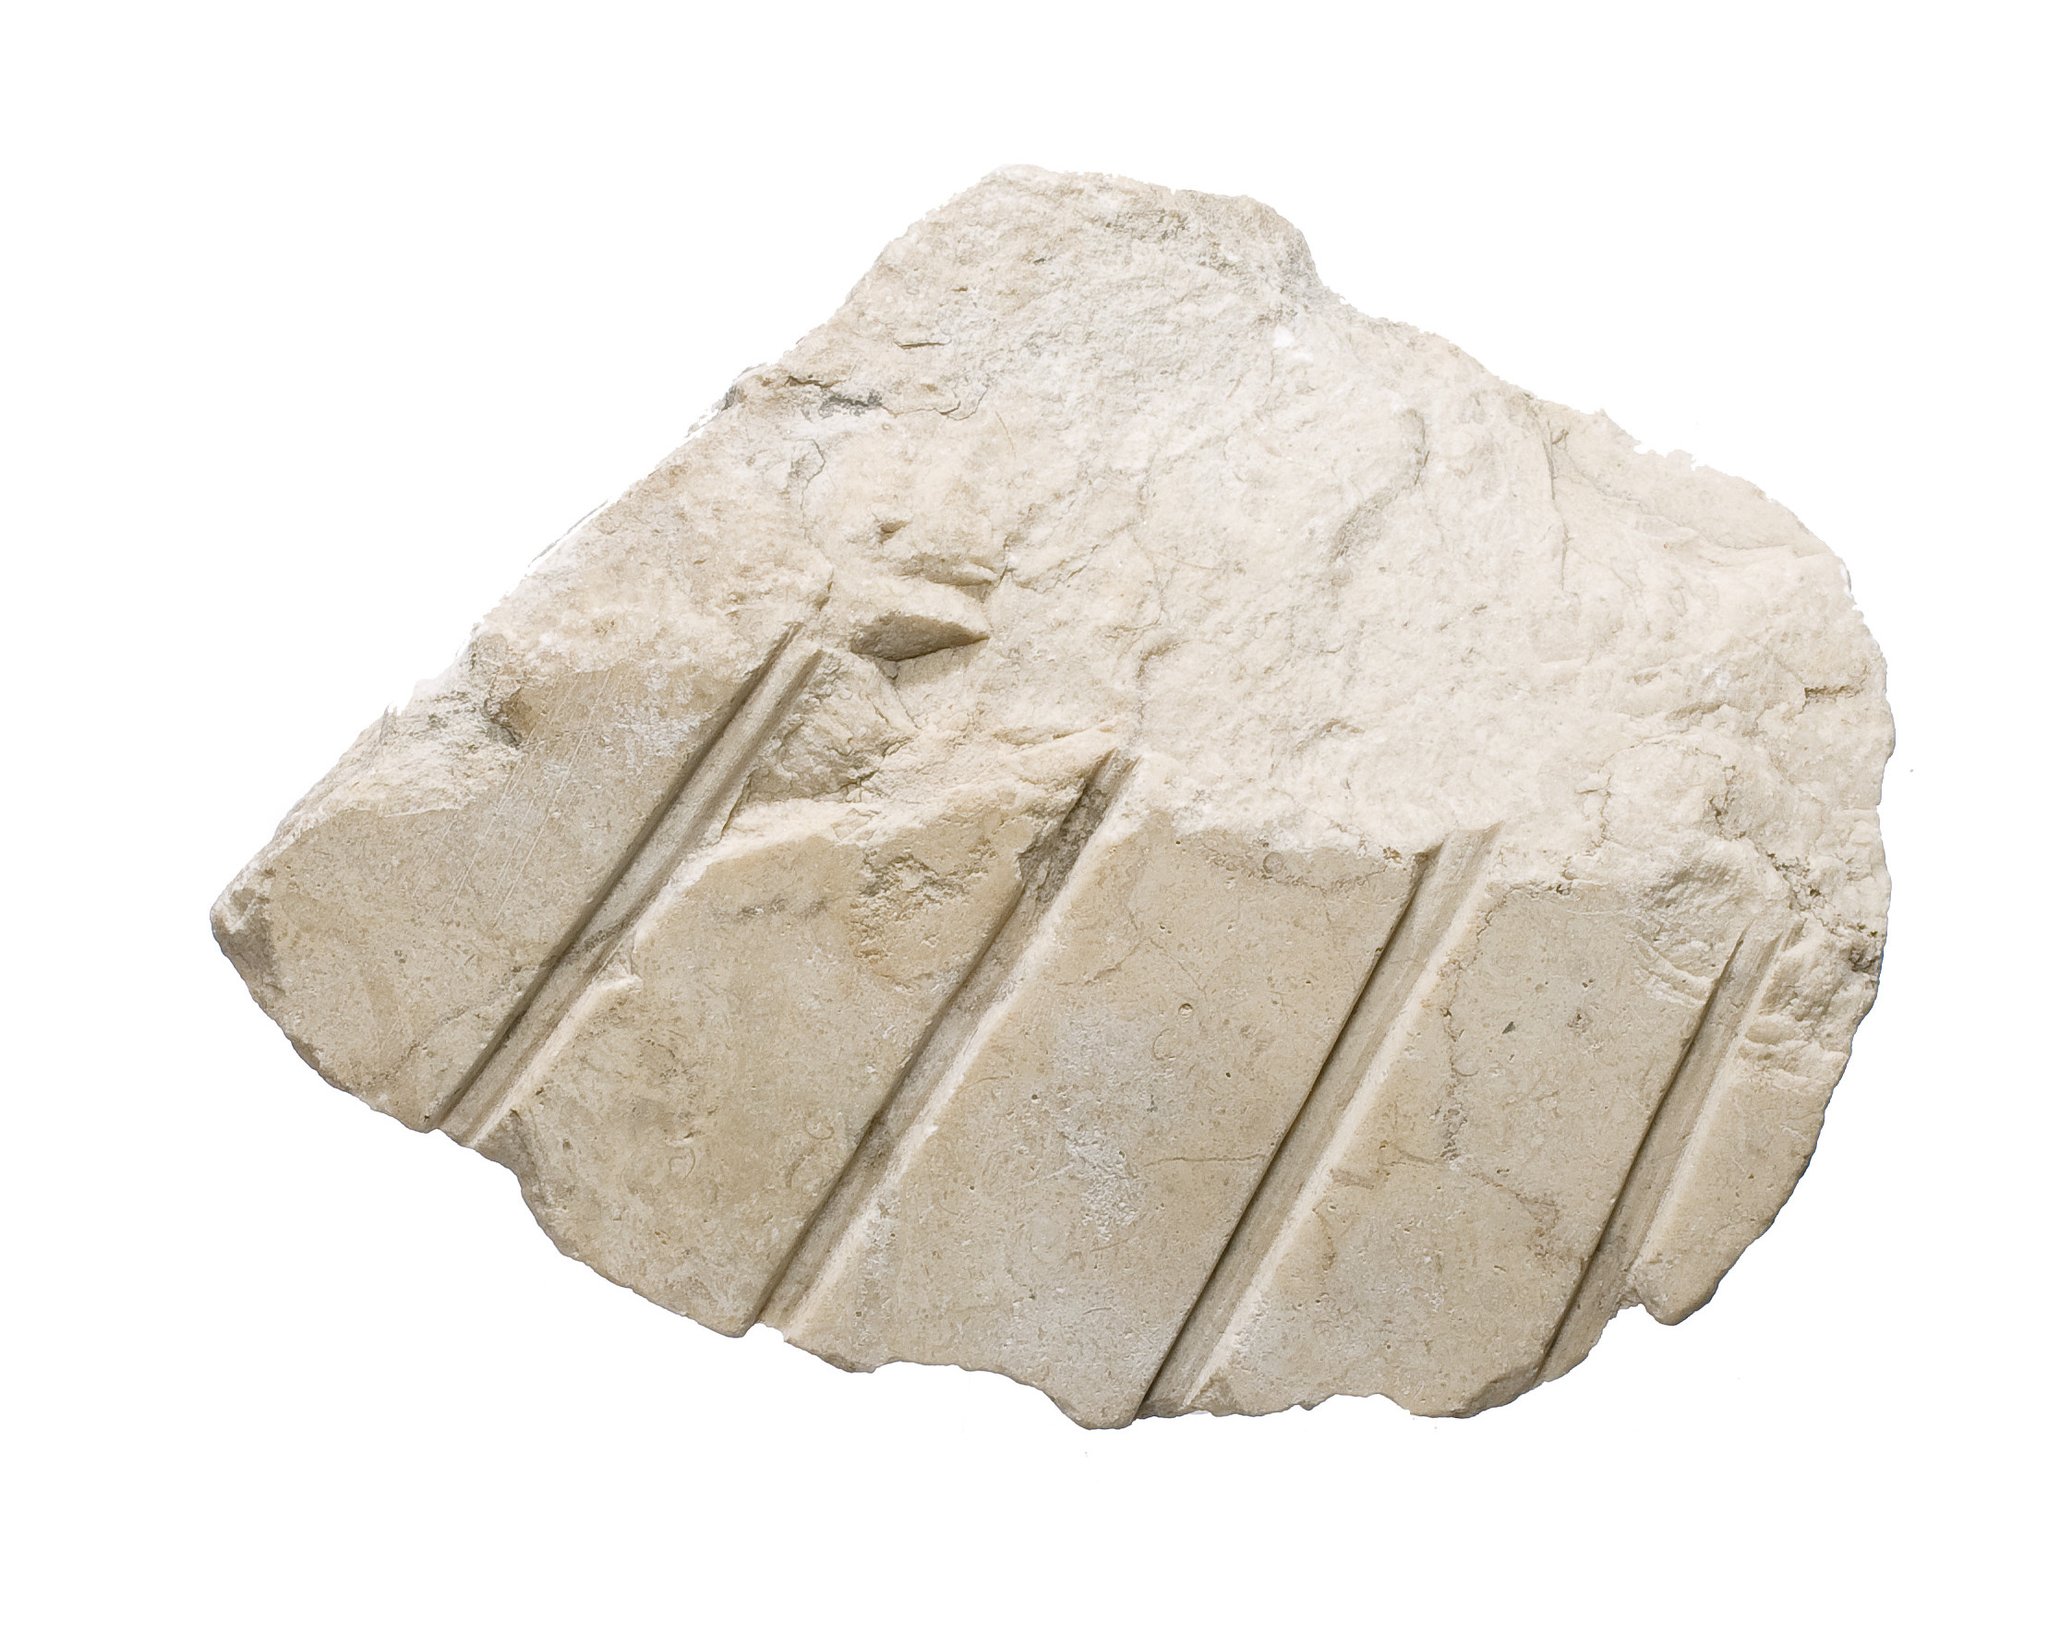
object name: pictorial relief, aten ray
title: Pictorial relief, Aten rays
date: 1353-1336 BCE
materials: limestone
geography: egypt